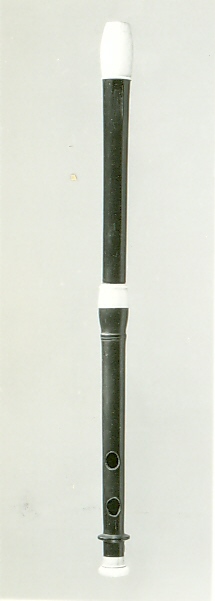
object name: tabor pipe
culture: french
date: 1701-1800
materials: ivory, wood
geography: france